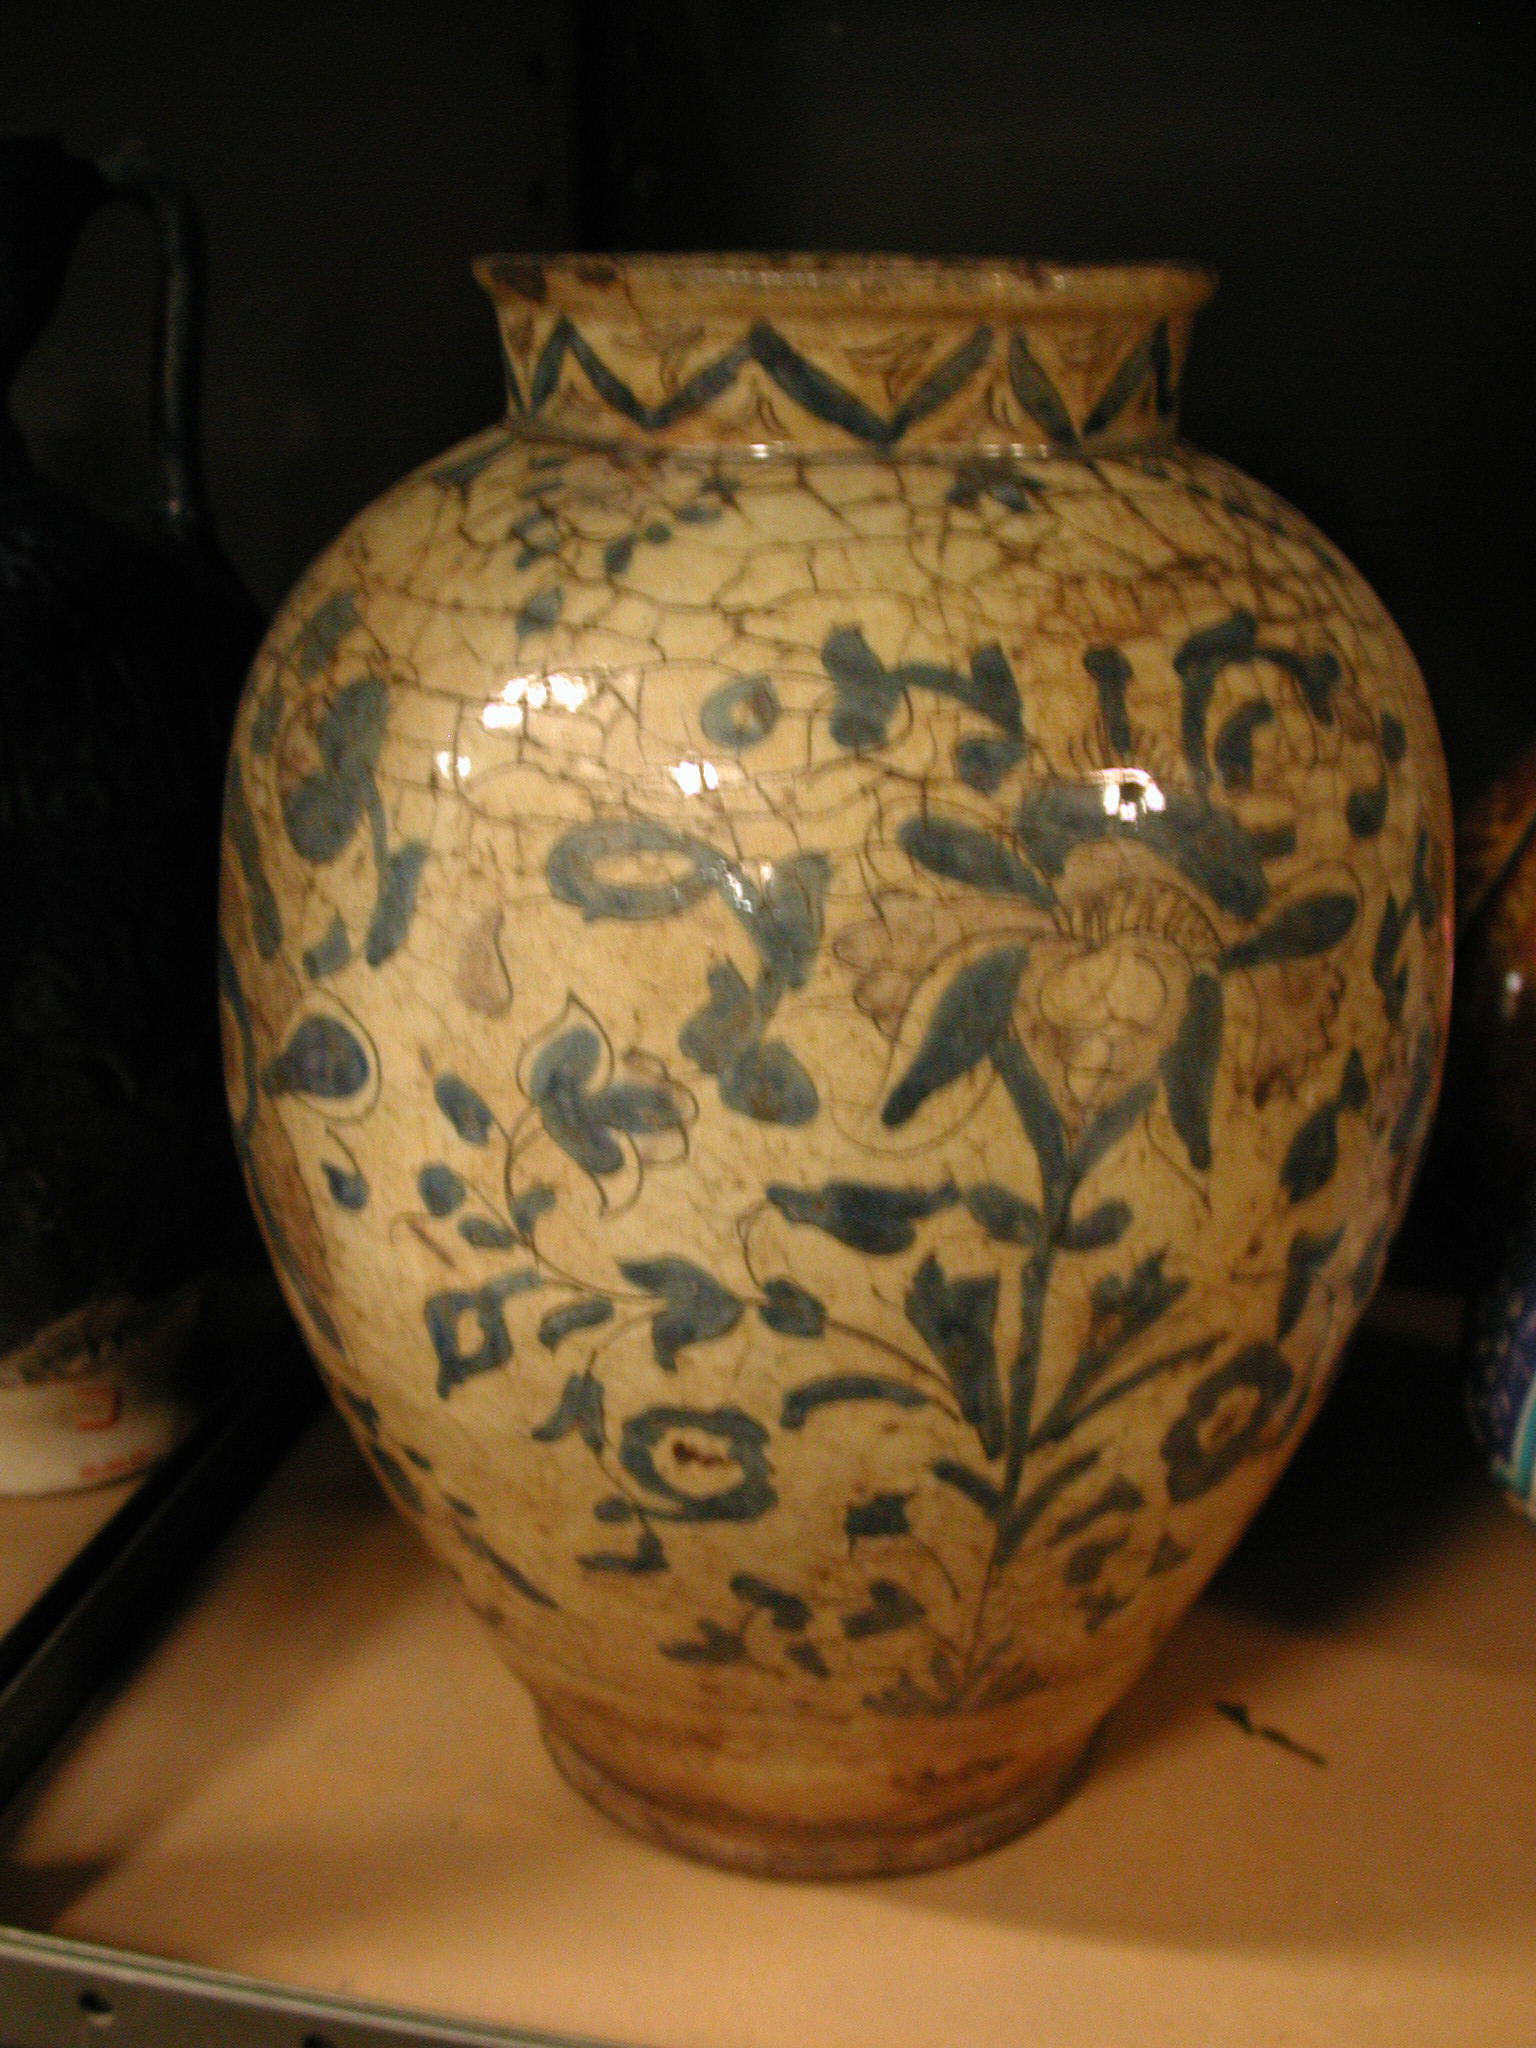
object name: jar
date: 1601-1700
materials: stonepaste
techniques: painting, underglaze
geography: iran